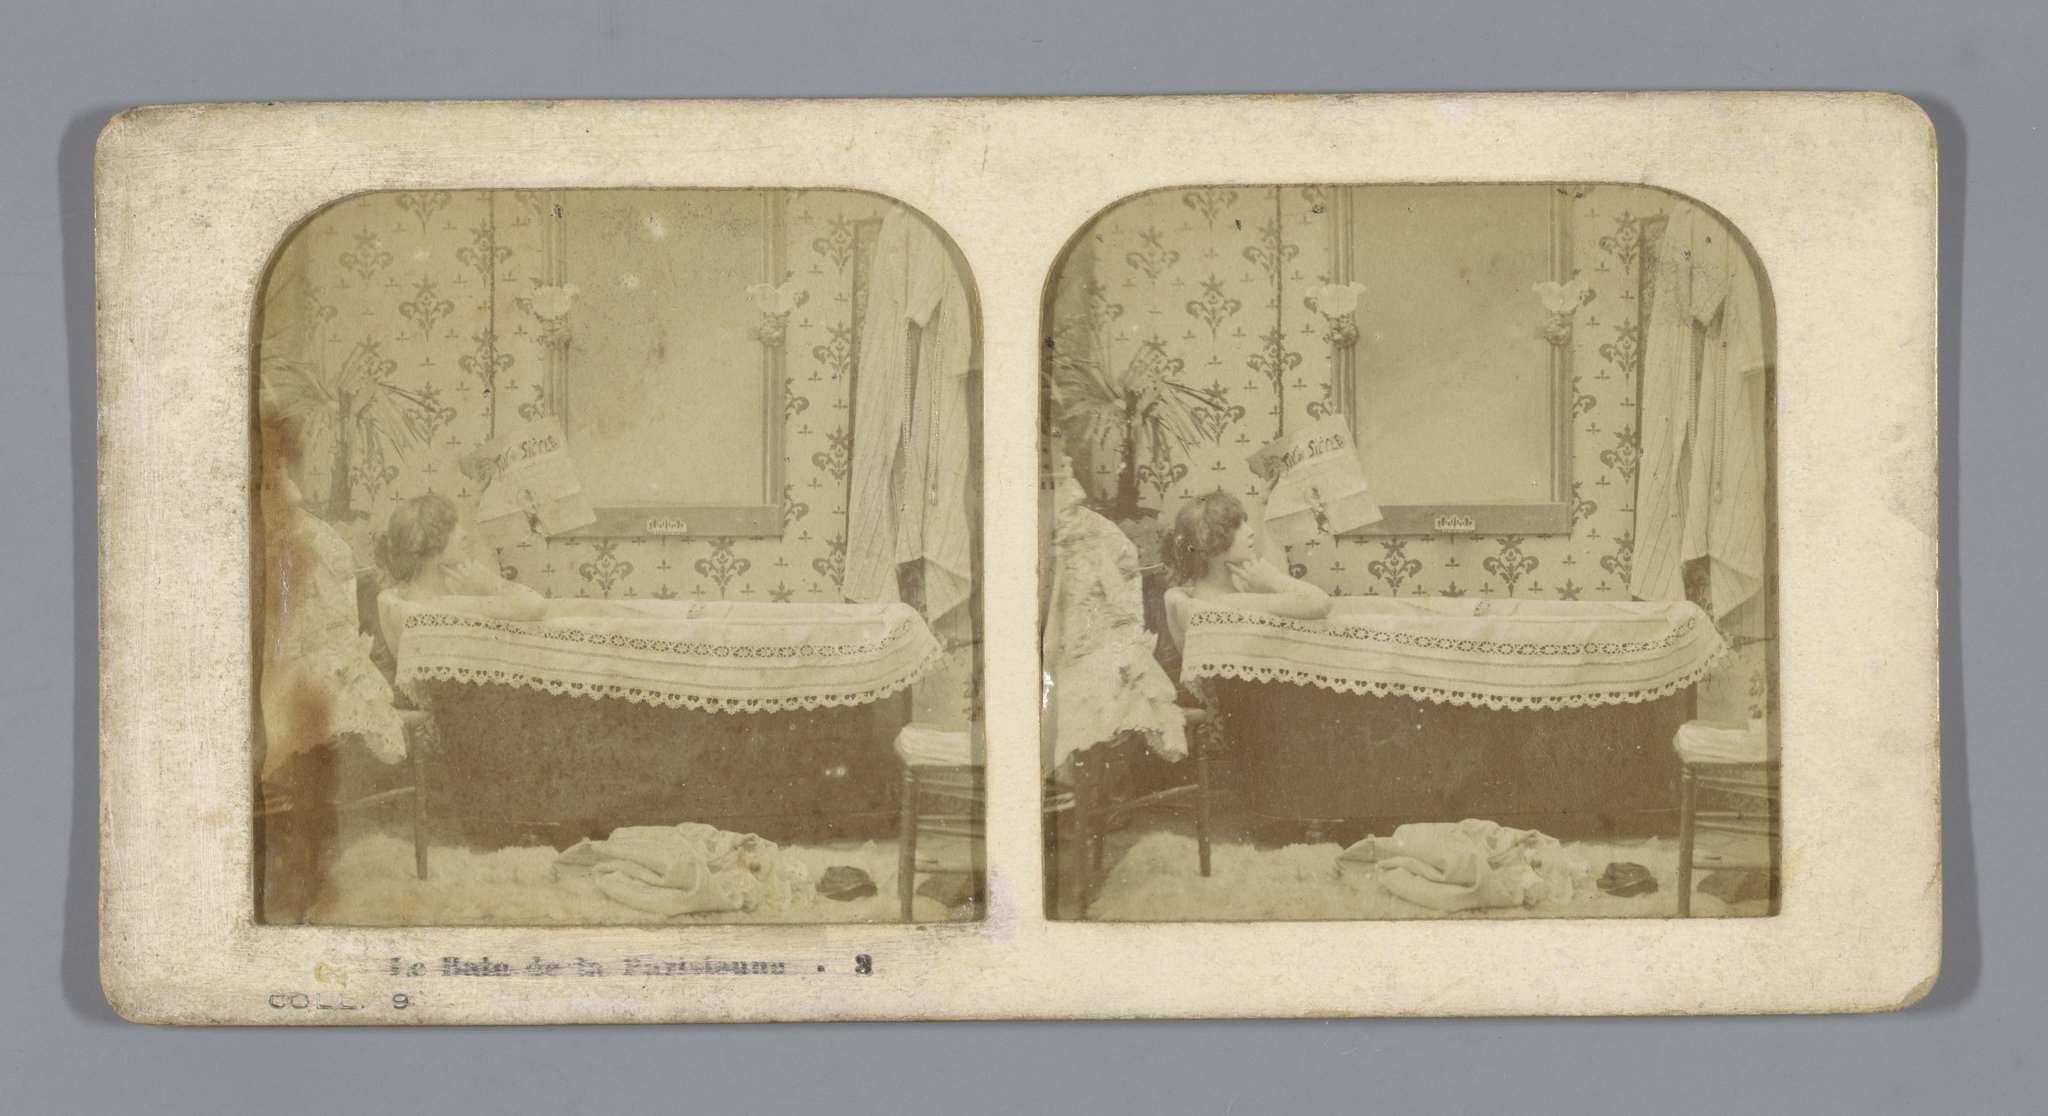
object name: tissue stereograph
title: Le Bain de la Parisienne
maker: Anonymous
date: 1894-1905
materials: cardboard, paper, photographic support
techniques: albumen print, hand coloring, perforating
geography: france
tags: taking a bath, france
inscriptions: number: ‘3’, inscription: ‘COLL. 9’